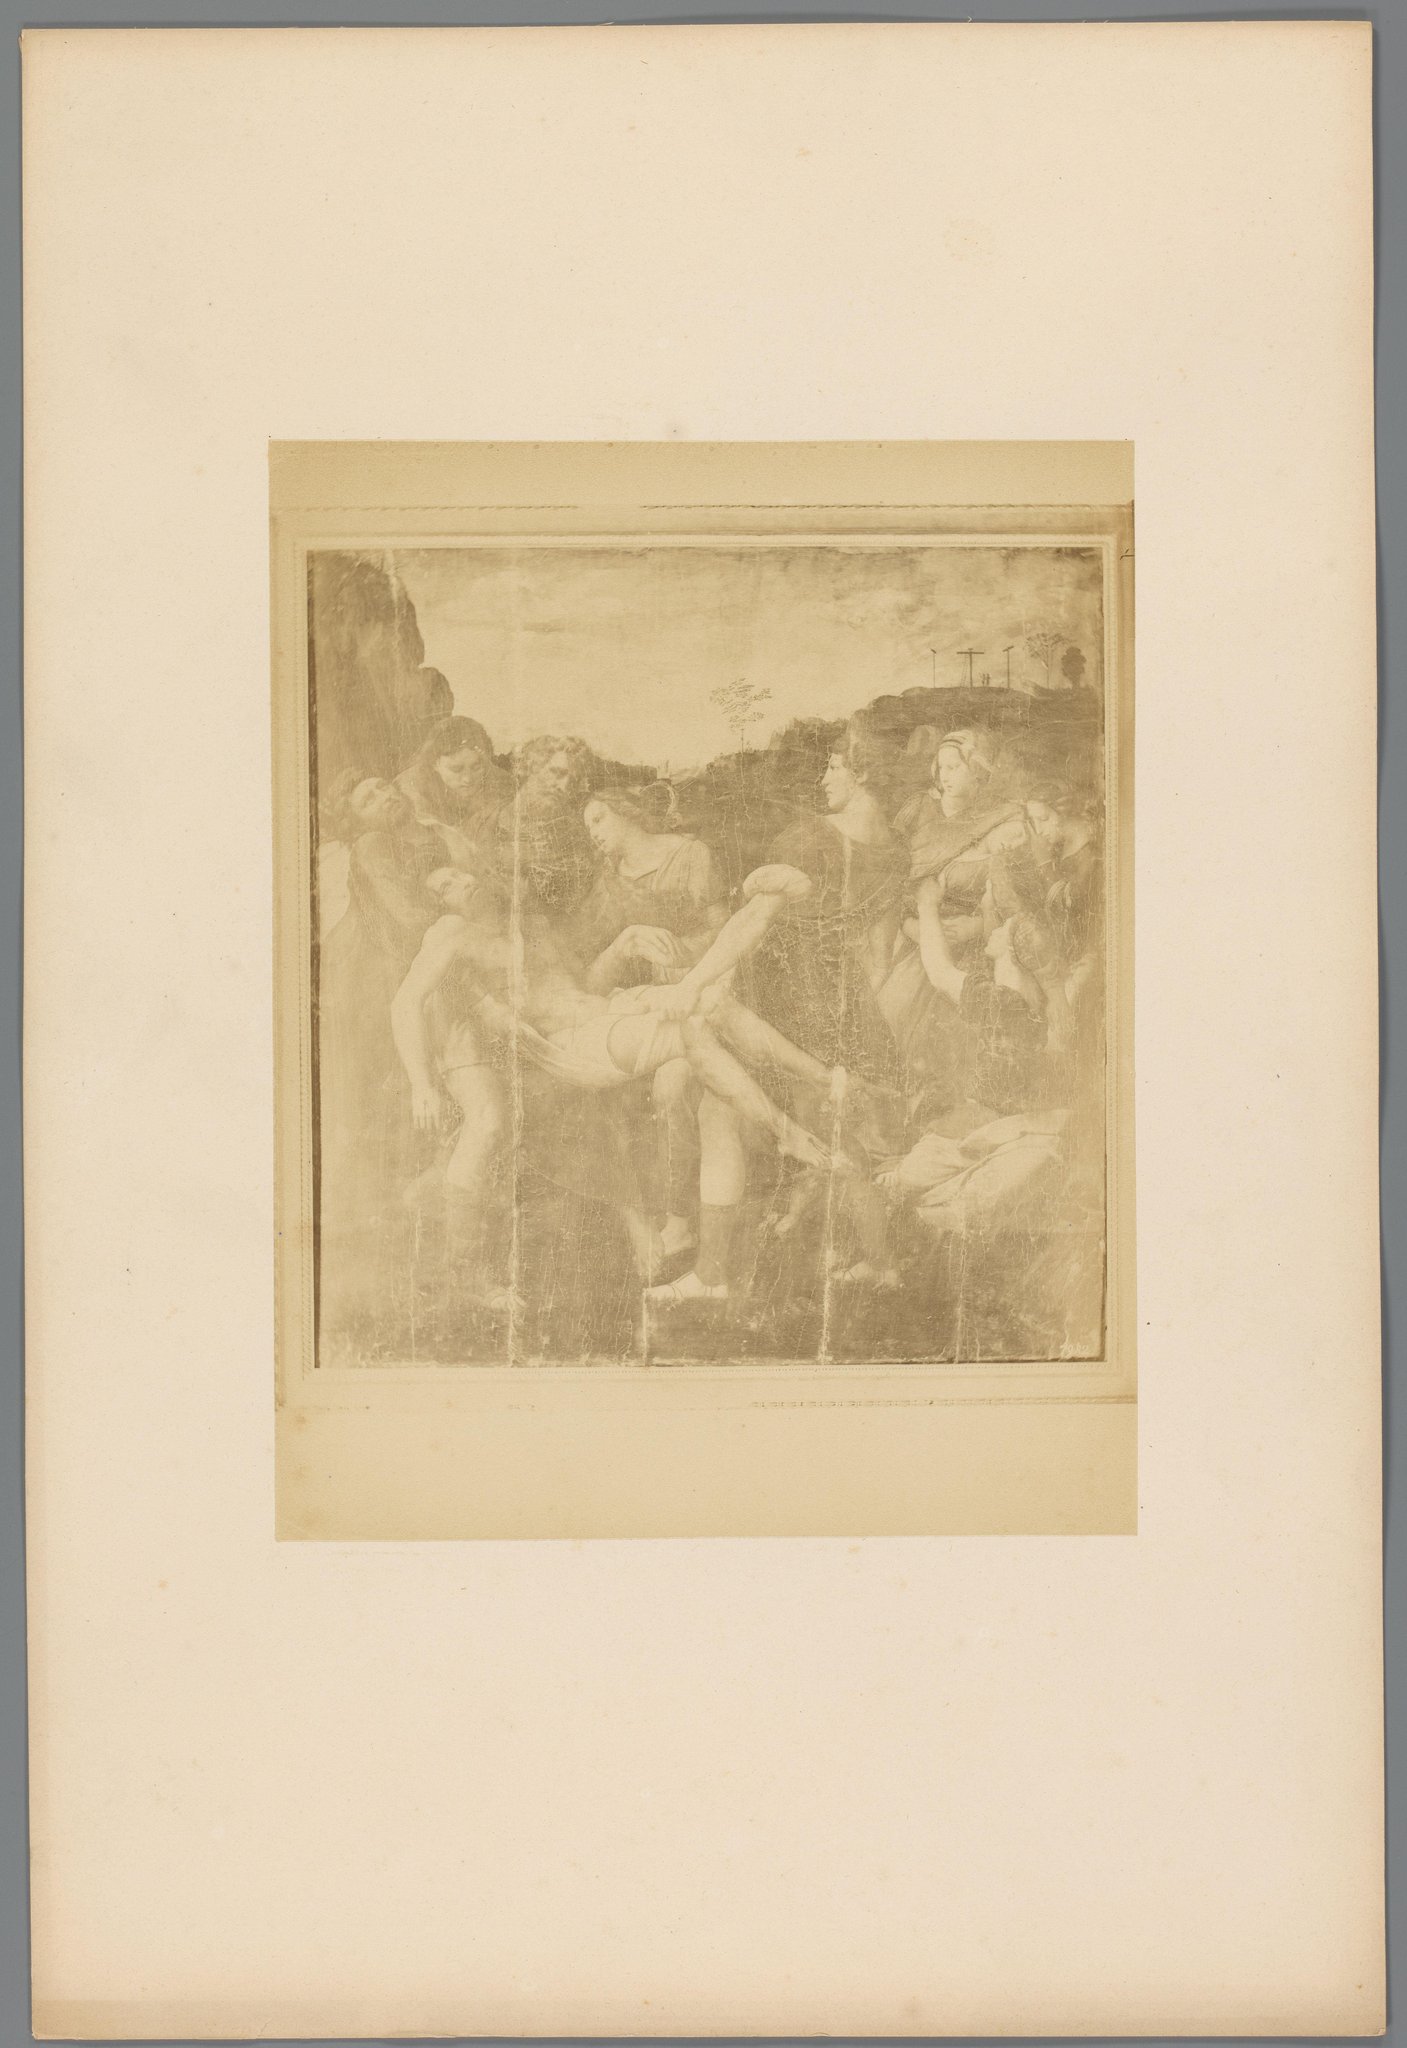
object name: reproduction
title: Fotoreproductie van een schilderij voorstellende de kruisafname van Christus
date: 1852-1900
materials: cardboard, paper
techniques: albumen print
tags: christ is laid down ~ descent from the cross